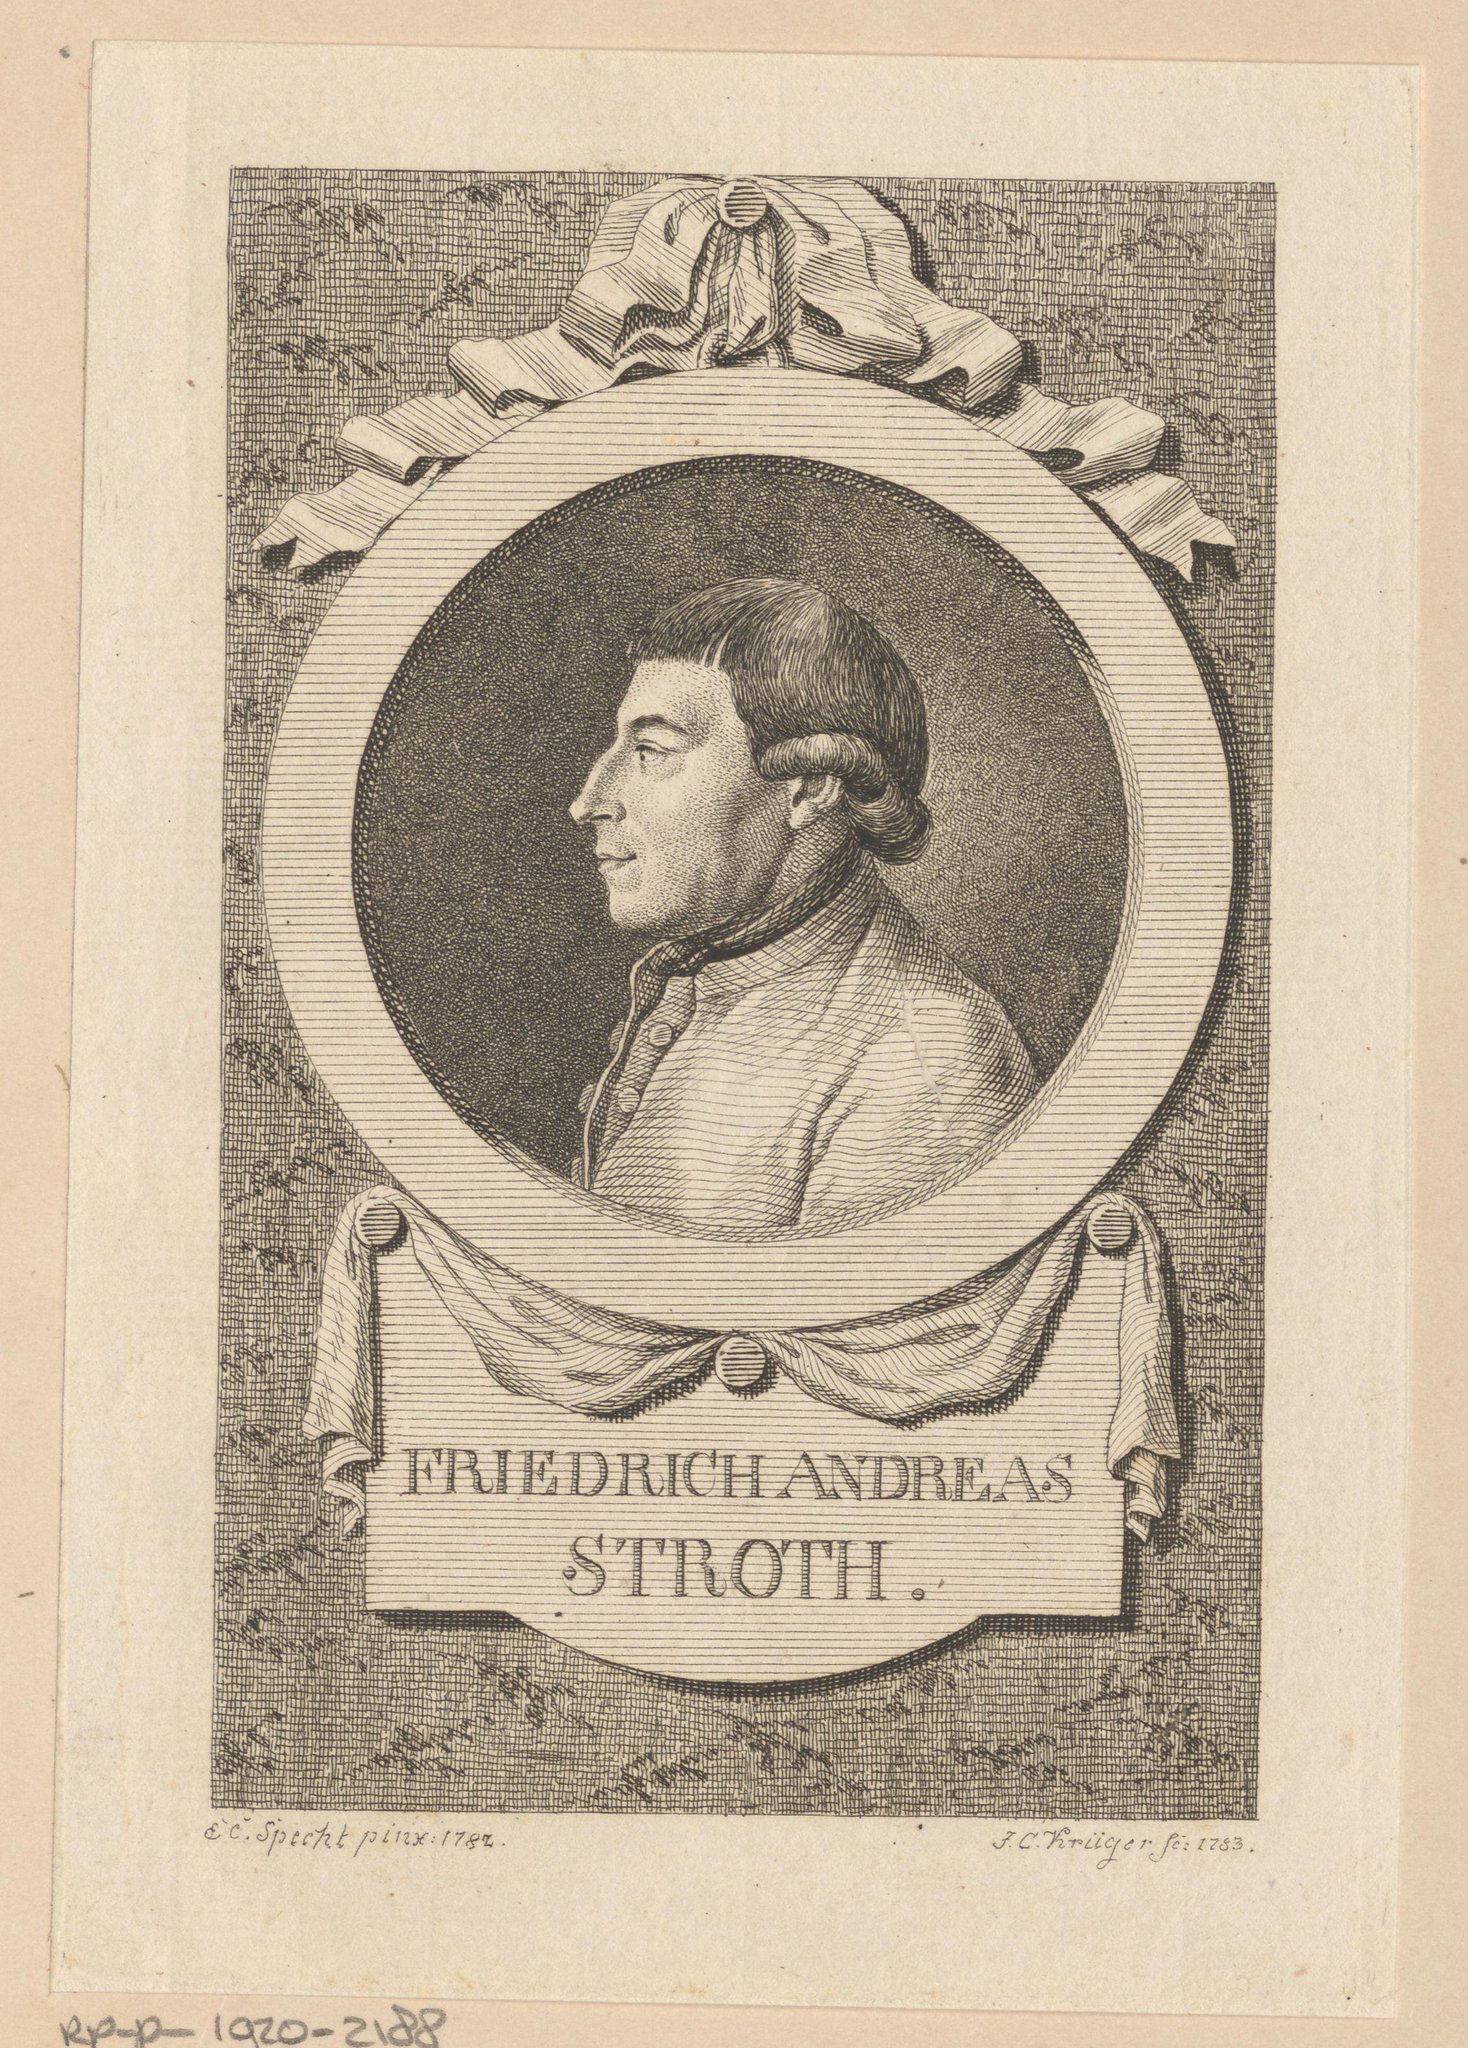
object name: print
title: Portret van Friedrich Andreas Stroth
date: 1783-1785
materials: paper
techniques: engraving, etching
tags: theologian, historical persons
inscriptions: collector's mark: Lugt 2228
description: Prent waarschijnlijk uit: Allgemeine deutsche Bibliothek. Berlijn: Friedrich Nicholai, 1785. dl.62.